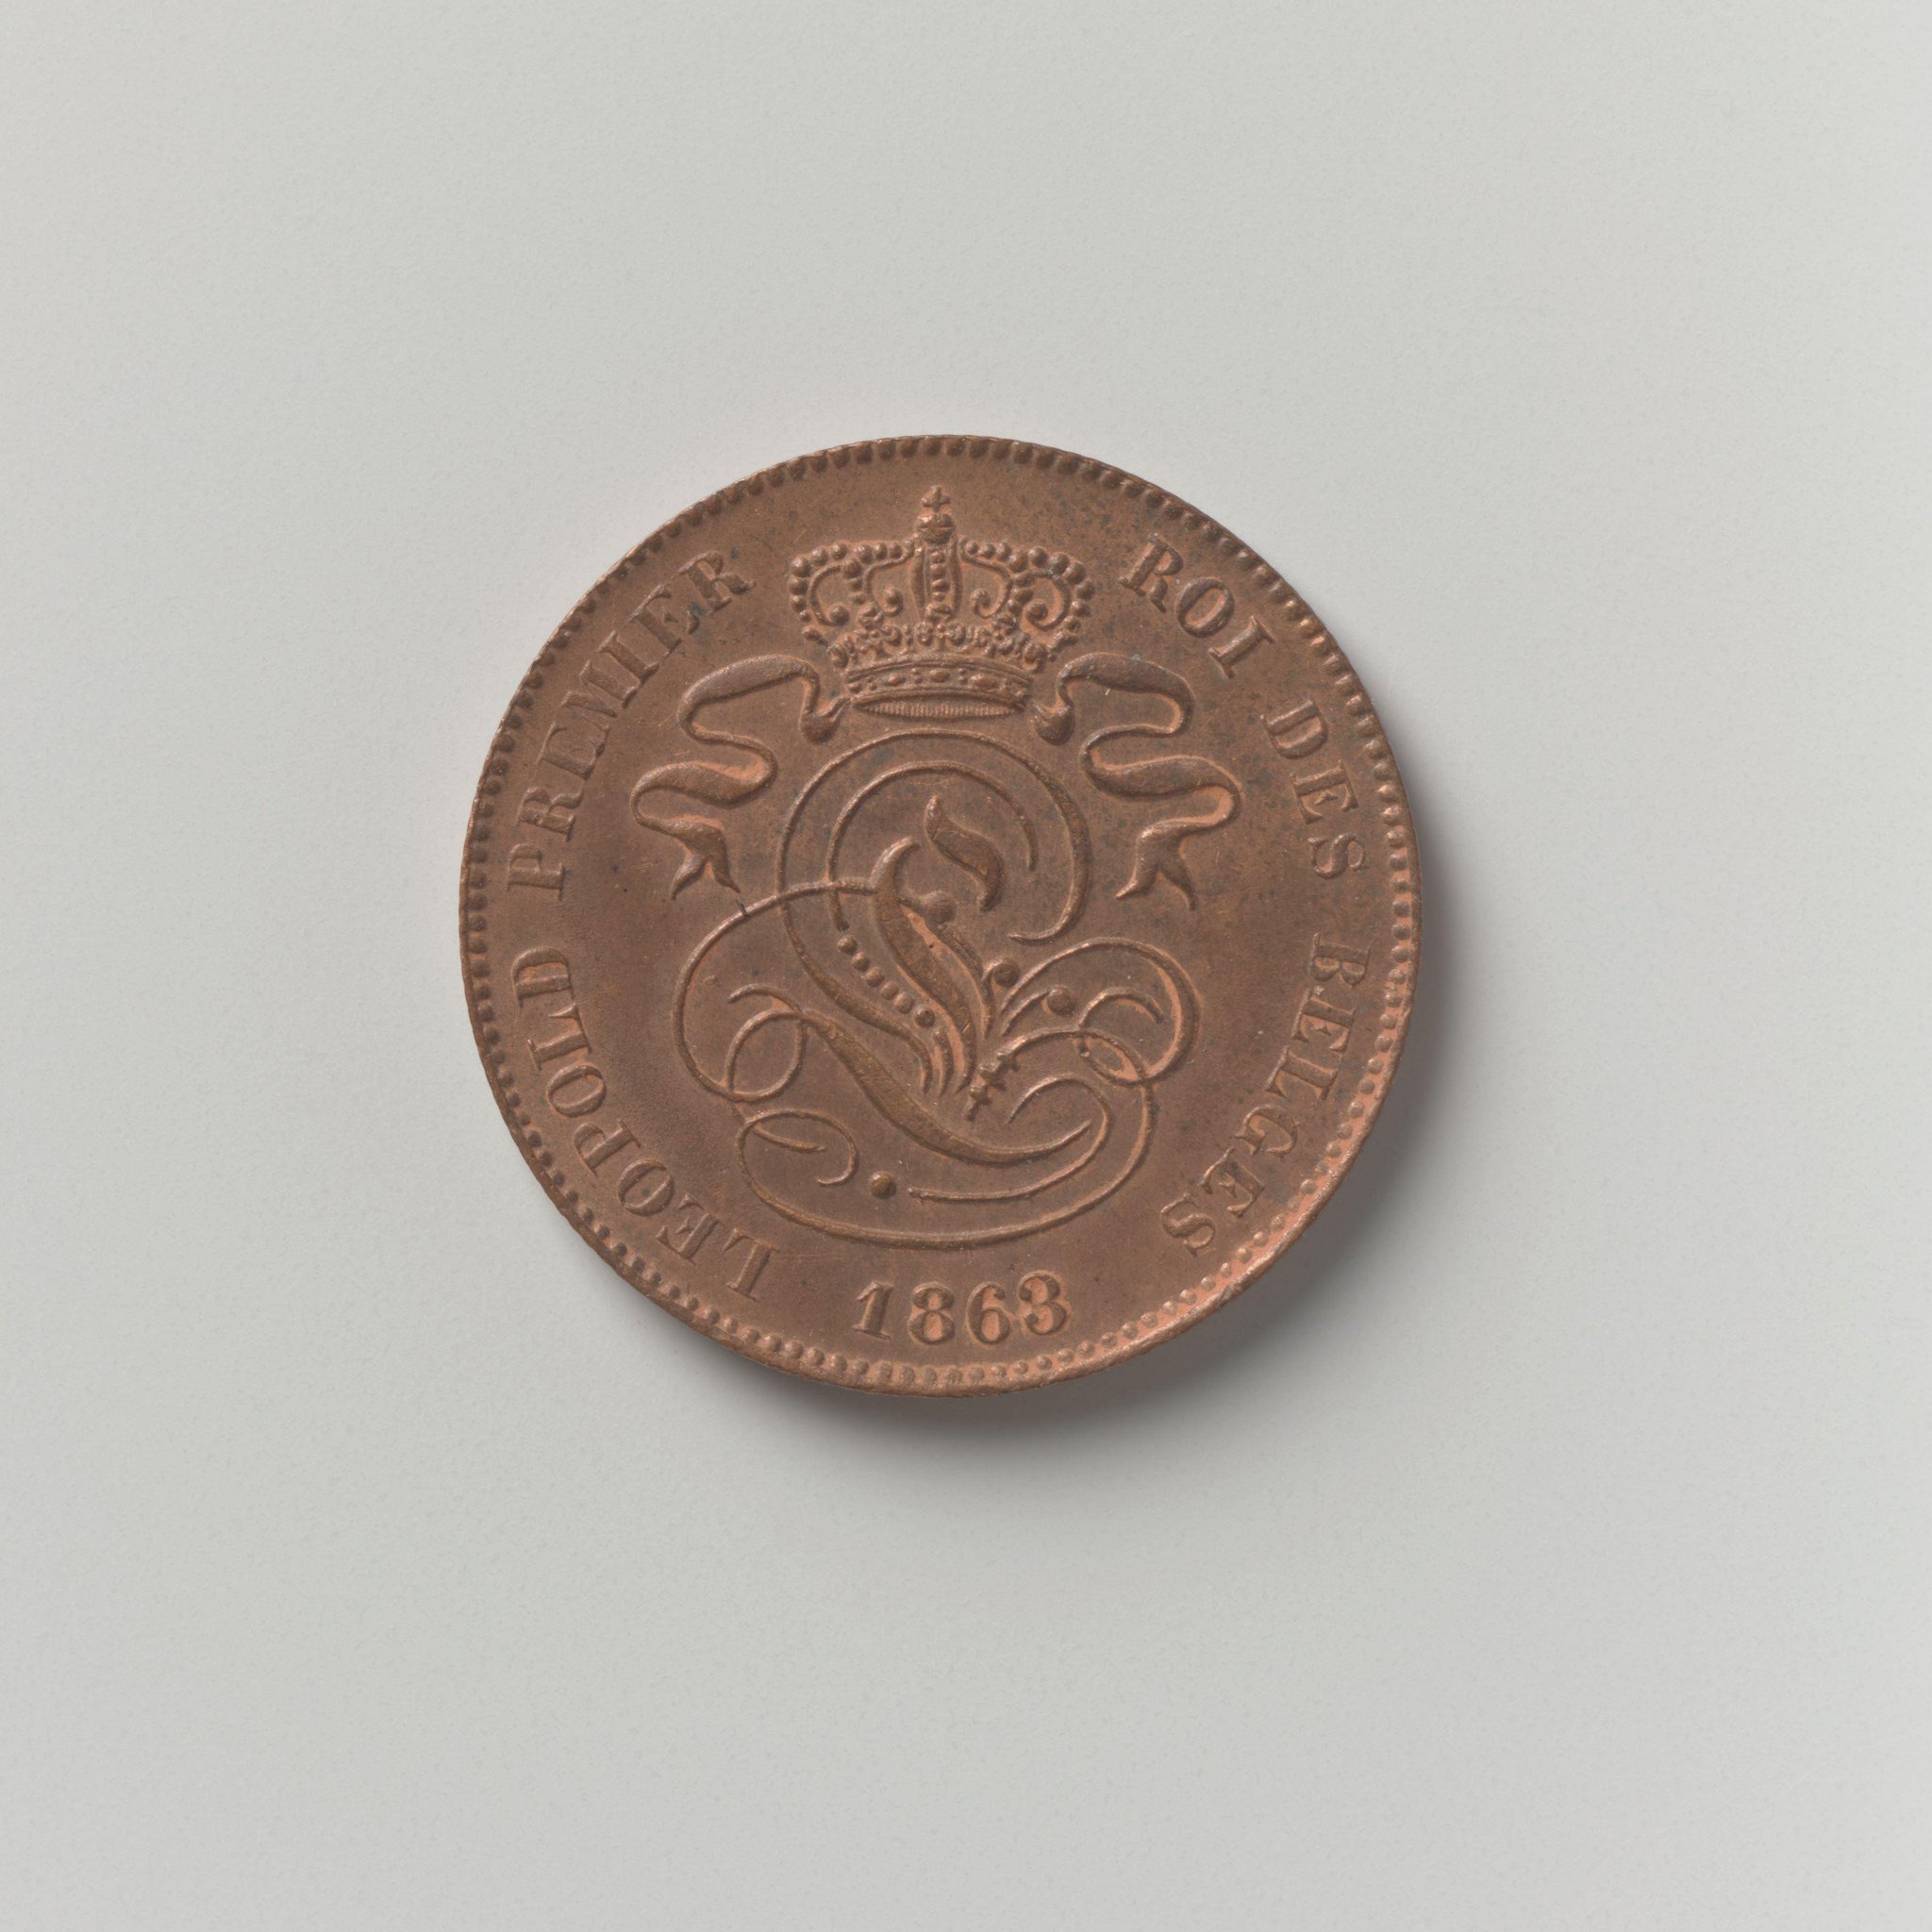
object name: coin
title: 2 centimes uit België van Leopold I, 1863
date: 1863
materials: copper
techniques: striking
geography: brussels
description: Koperen munt. Voorzijde: zittende, omkijkende leeuw naar links met onder rechter klauw paneel met opschrift. In afsnede waarde-aanduiding. Keerzijde: gekroond monogram. Jaartal onderaan. Kartelrand.